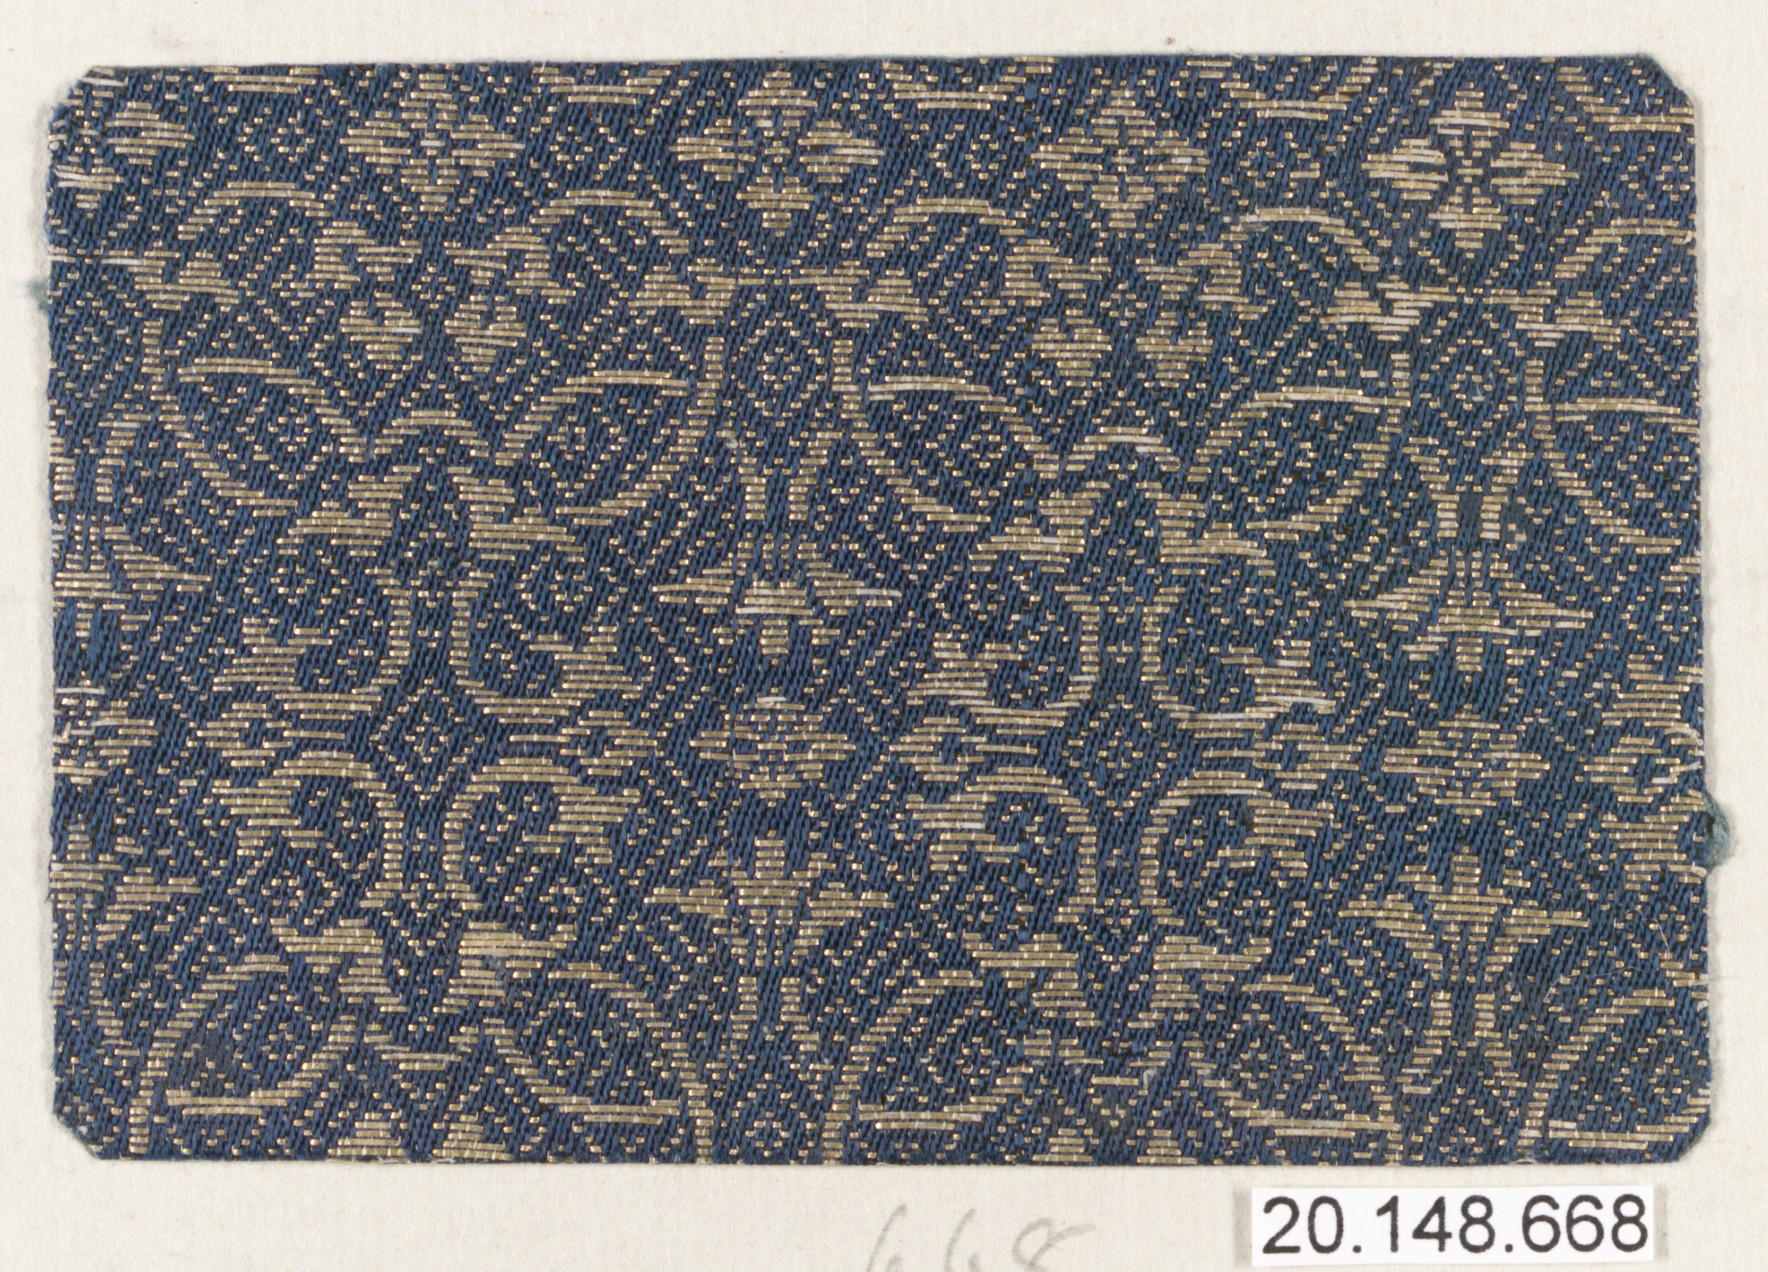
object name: piece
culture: japanese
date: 1701-1800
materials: silk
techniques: compound weave